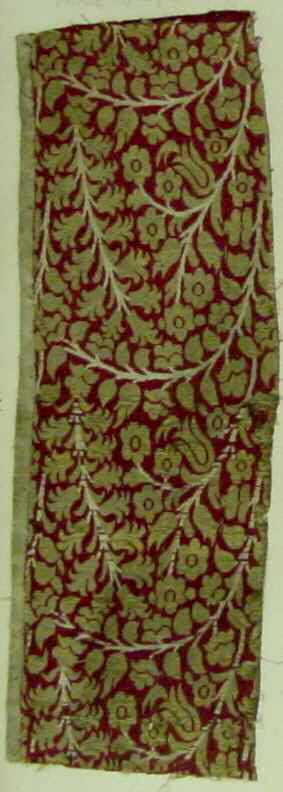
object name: textile fragment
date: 1567-1633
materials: metal thread, silk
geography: turkey